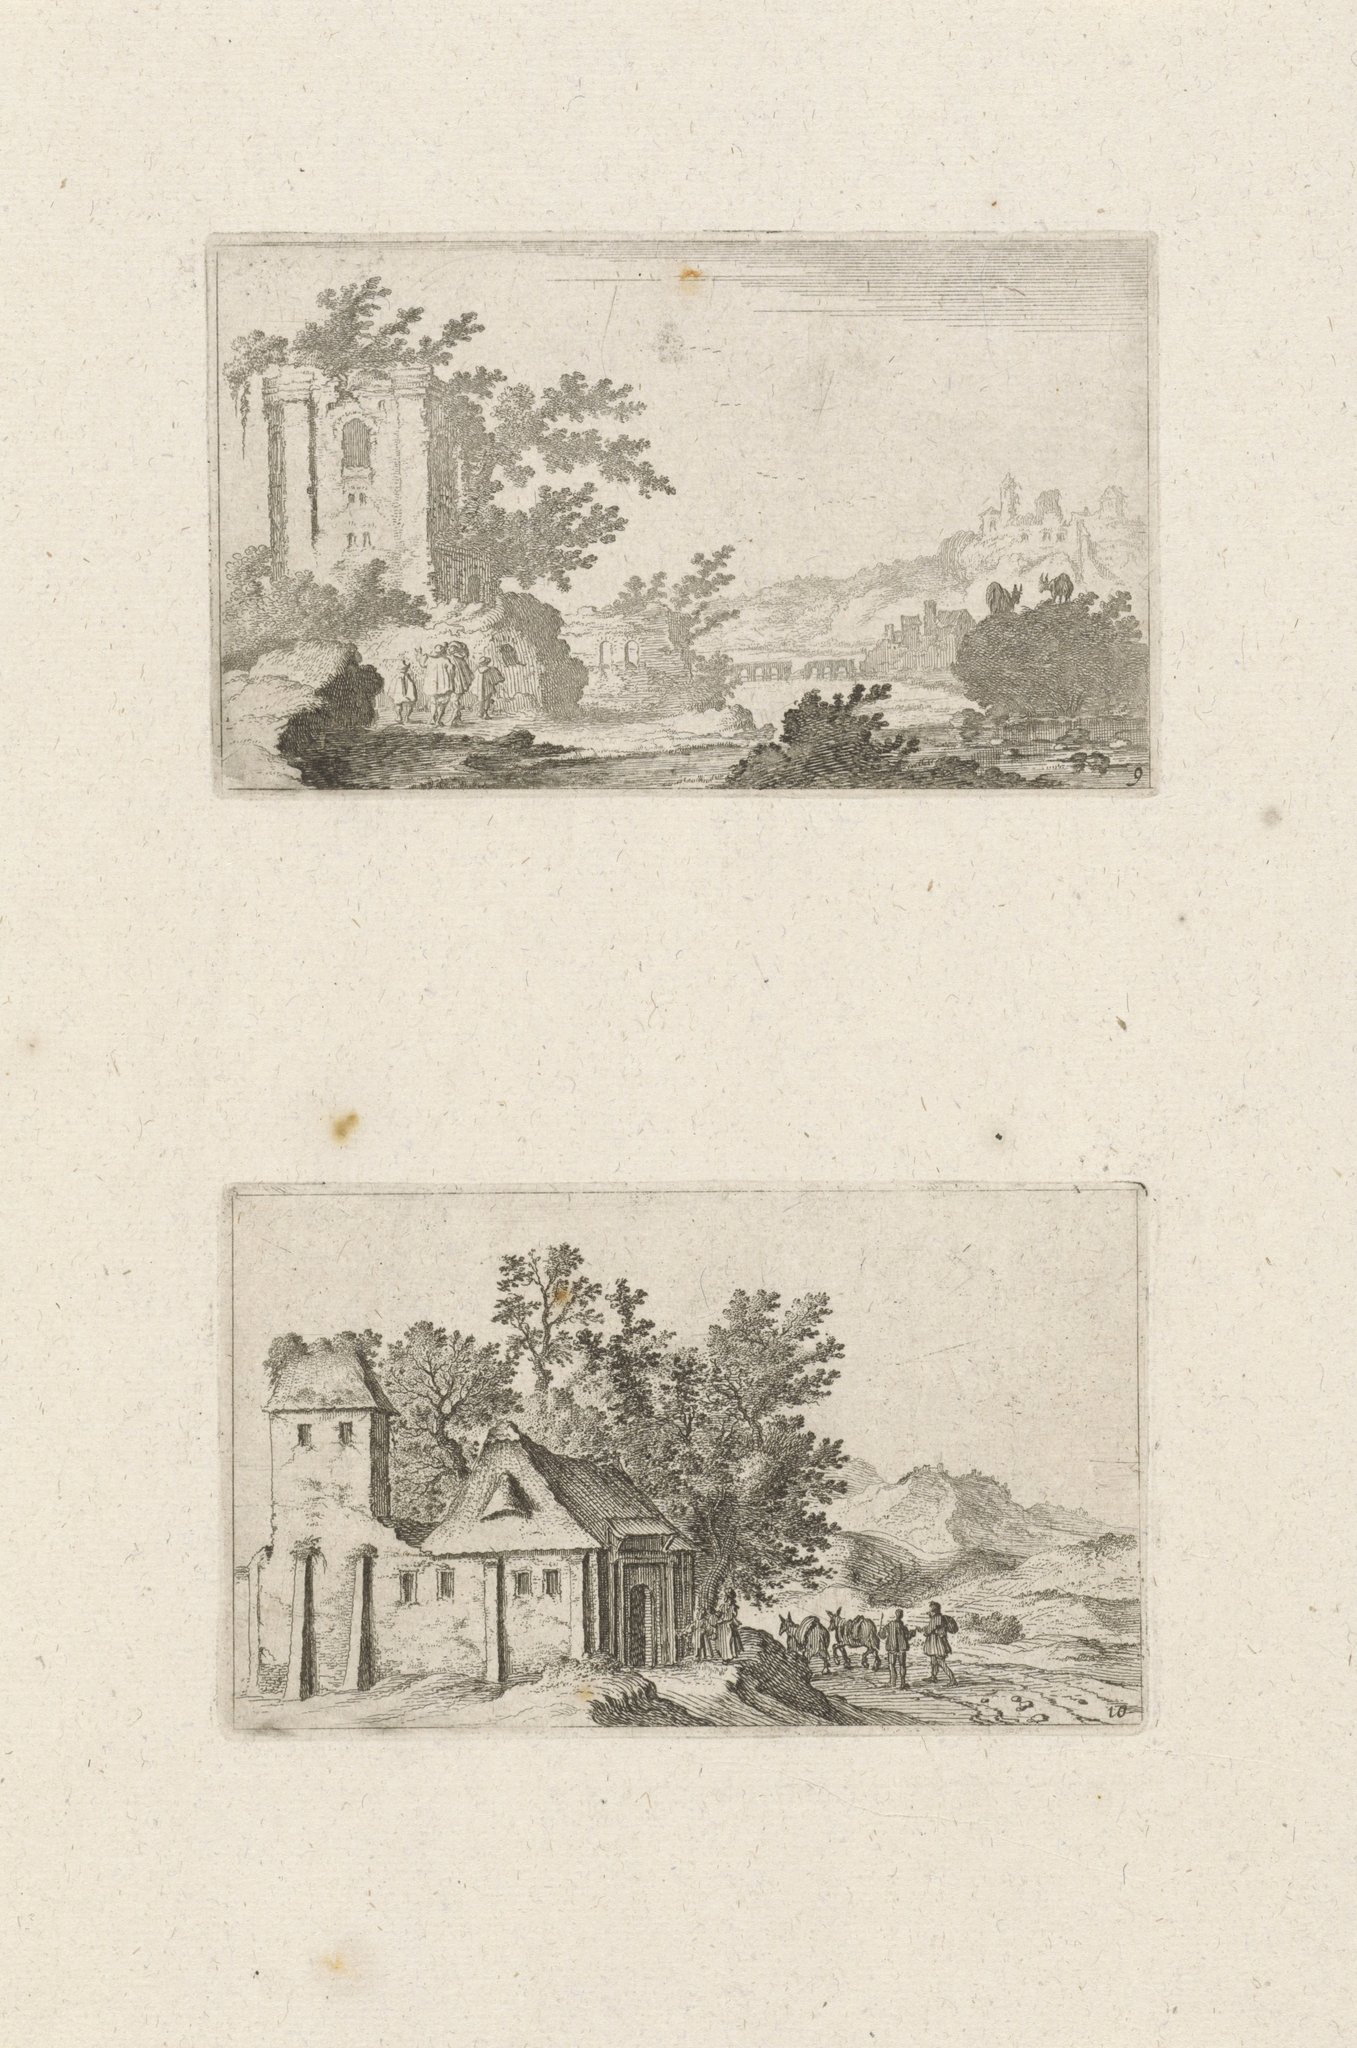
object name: print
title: Landschappen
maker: gillis van scheyndel (i)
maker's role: draughtsman, print maker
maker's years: 1595-1660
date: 1605-1653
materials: paper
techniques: engraving, etching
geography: netherlands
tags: river, ruin of a building ~ architecture, 'en route', traveller under way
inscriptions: collector's mark: Lugt 2228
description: Blad met twee afbeeldingen. Boven: een heuvelachtig landschap een ruïne en op de voorgrond enkele figuren. Op de achtergrond een rivier. Onder: een heuvelland met een boerderij waar twee enige figuren voor staan. De prenten maken deel uit van een serie van twaalf landschappen.